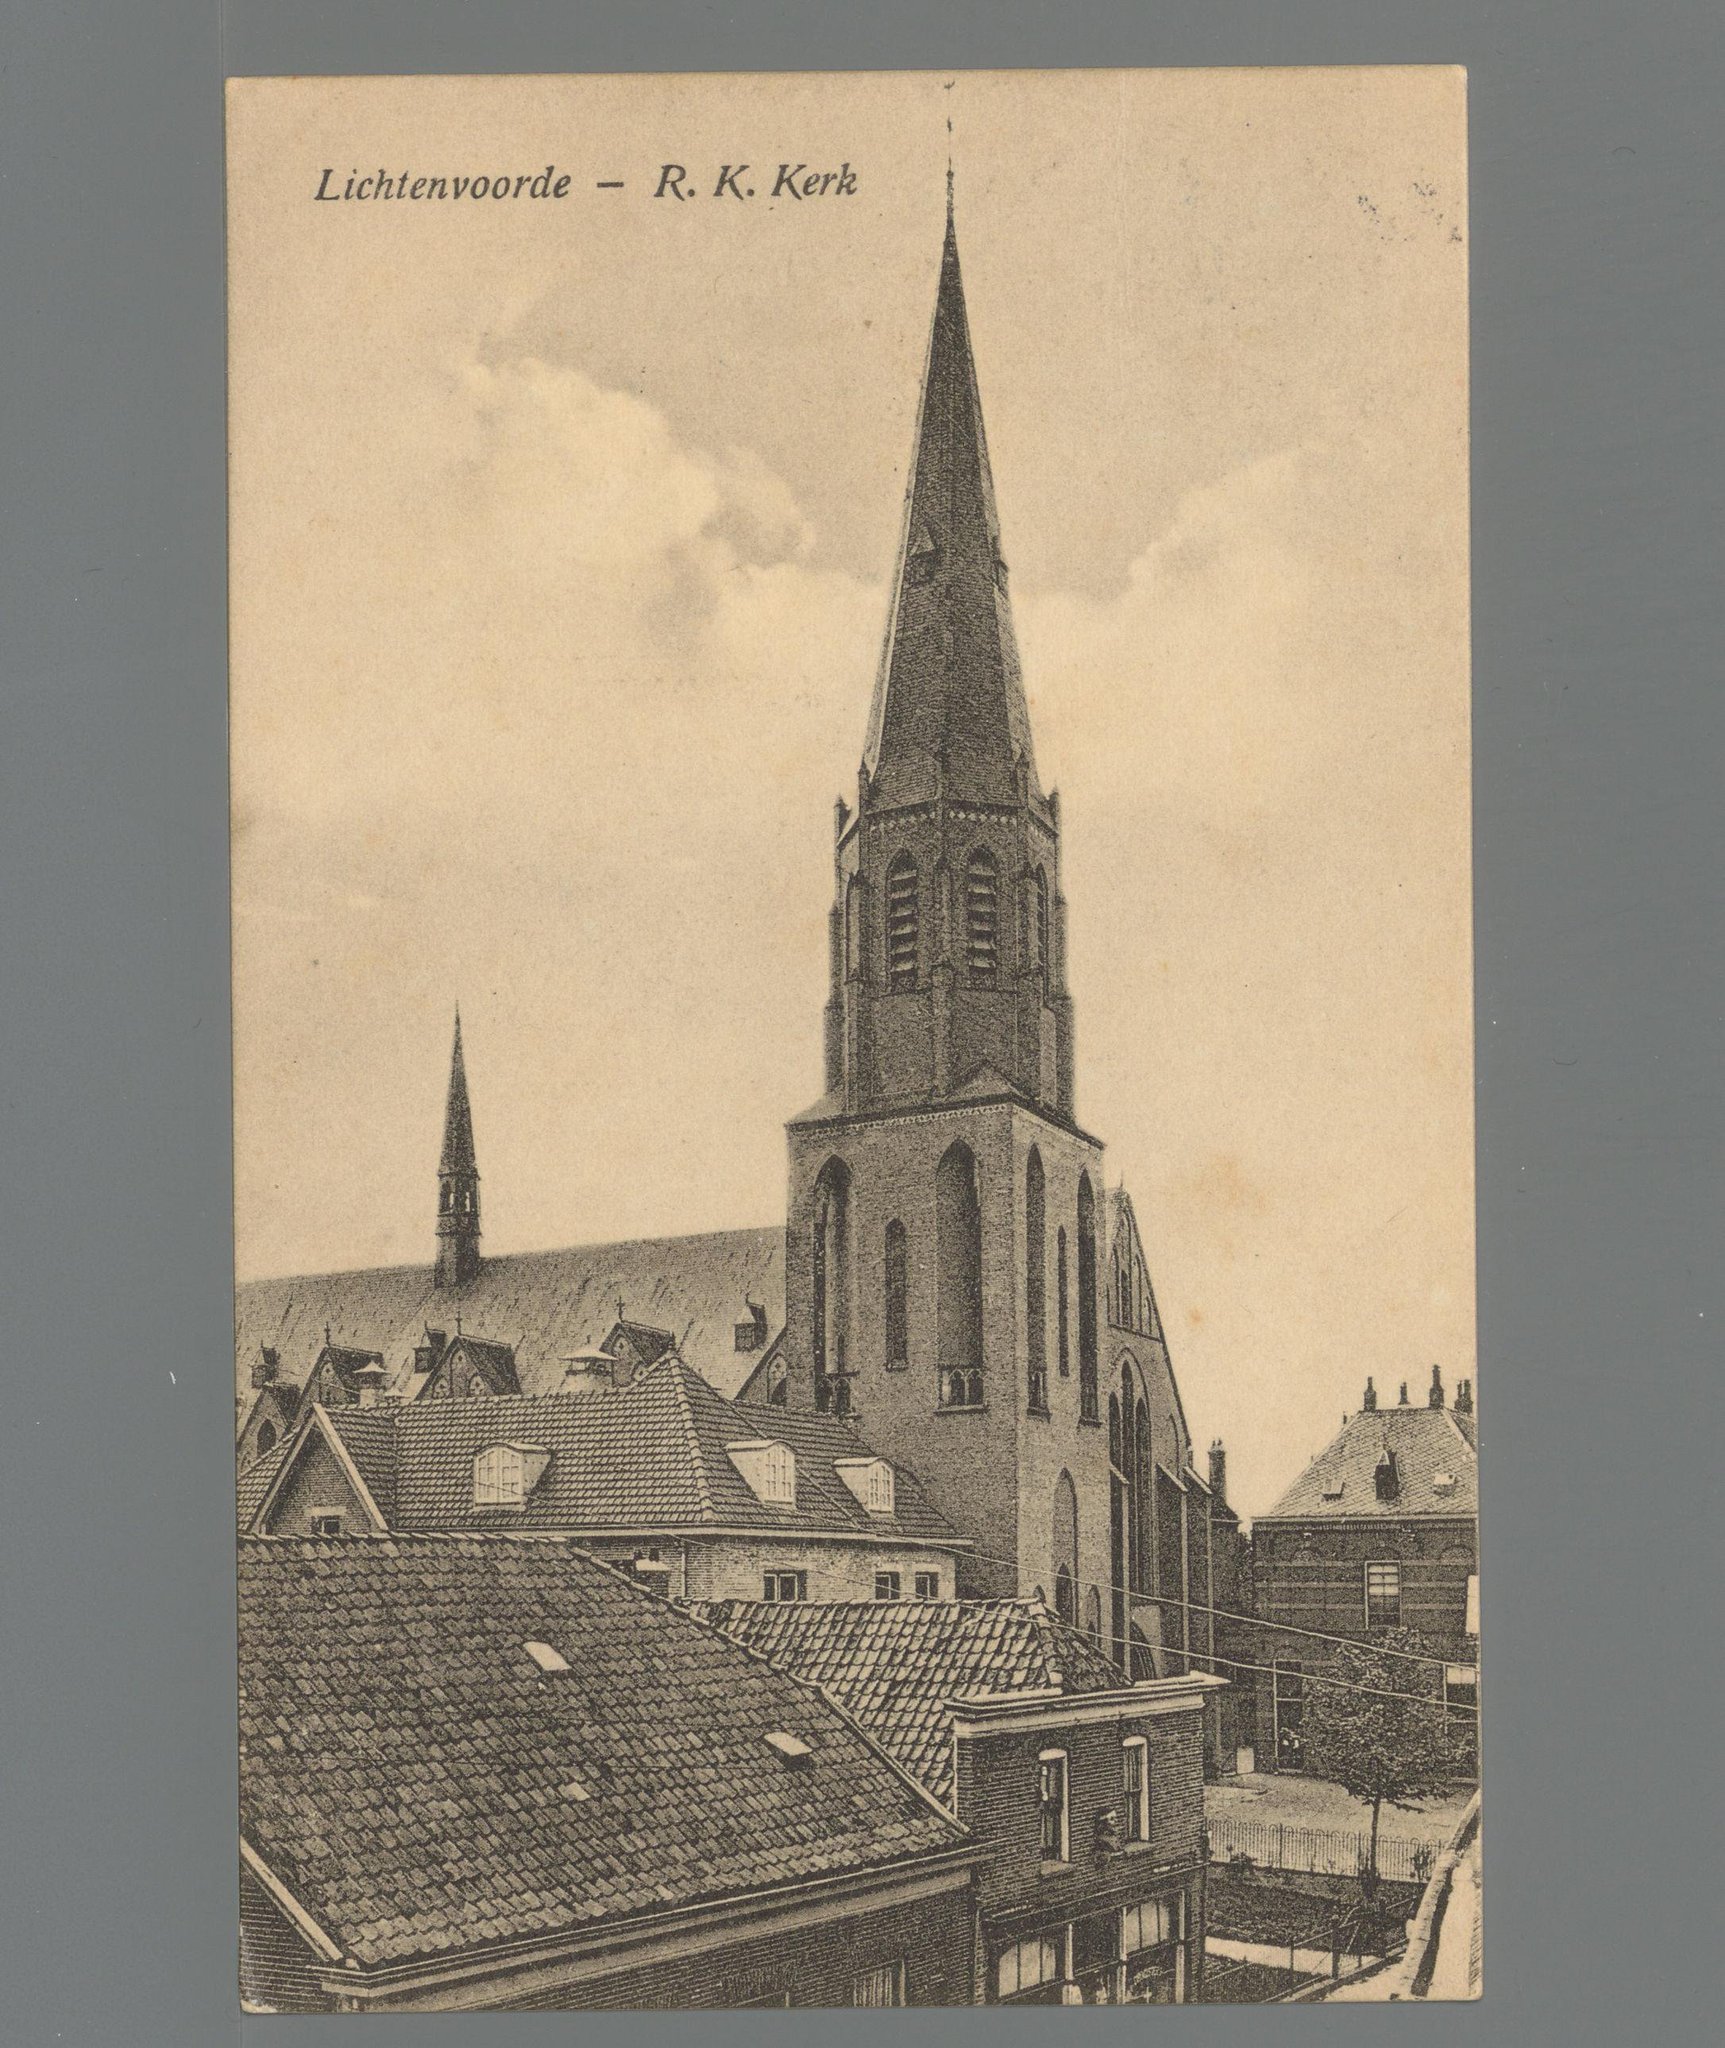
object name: photomechanical print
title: Lichtenvoorde - R. K. Kerk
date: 1905-1927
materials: cardboard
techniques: photograph, writing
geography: lichtenvoorde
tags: church (exterior)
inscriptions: poststempel, verso, gestempeld